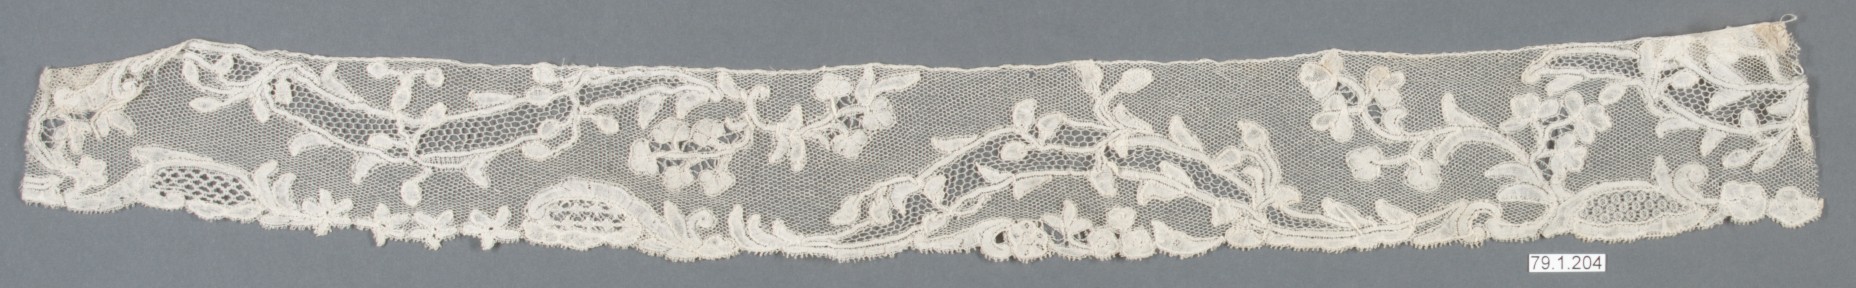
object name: strip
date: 1701-1800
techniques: lace